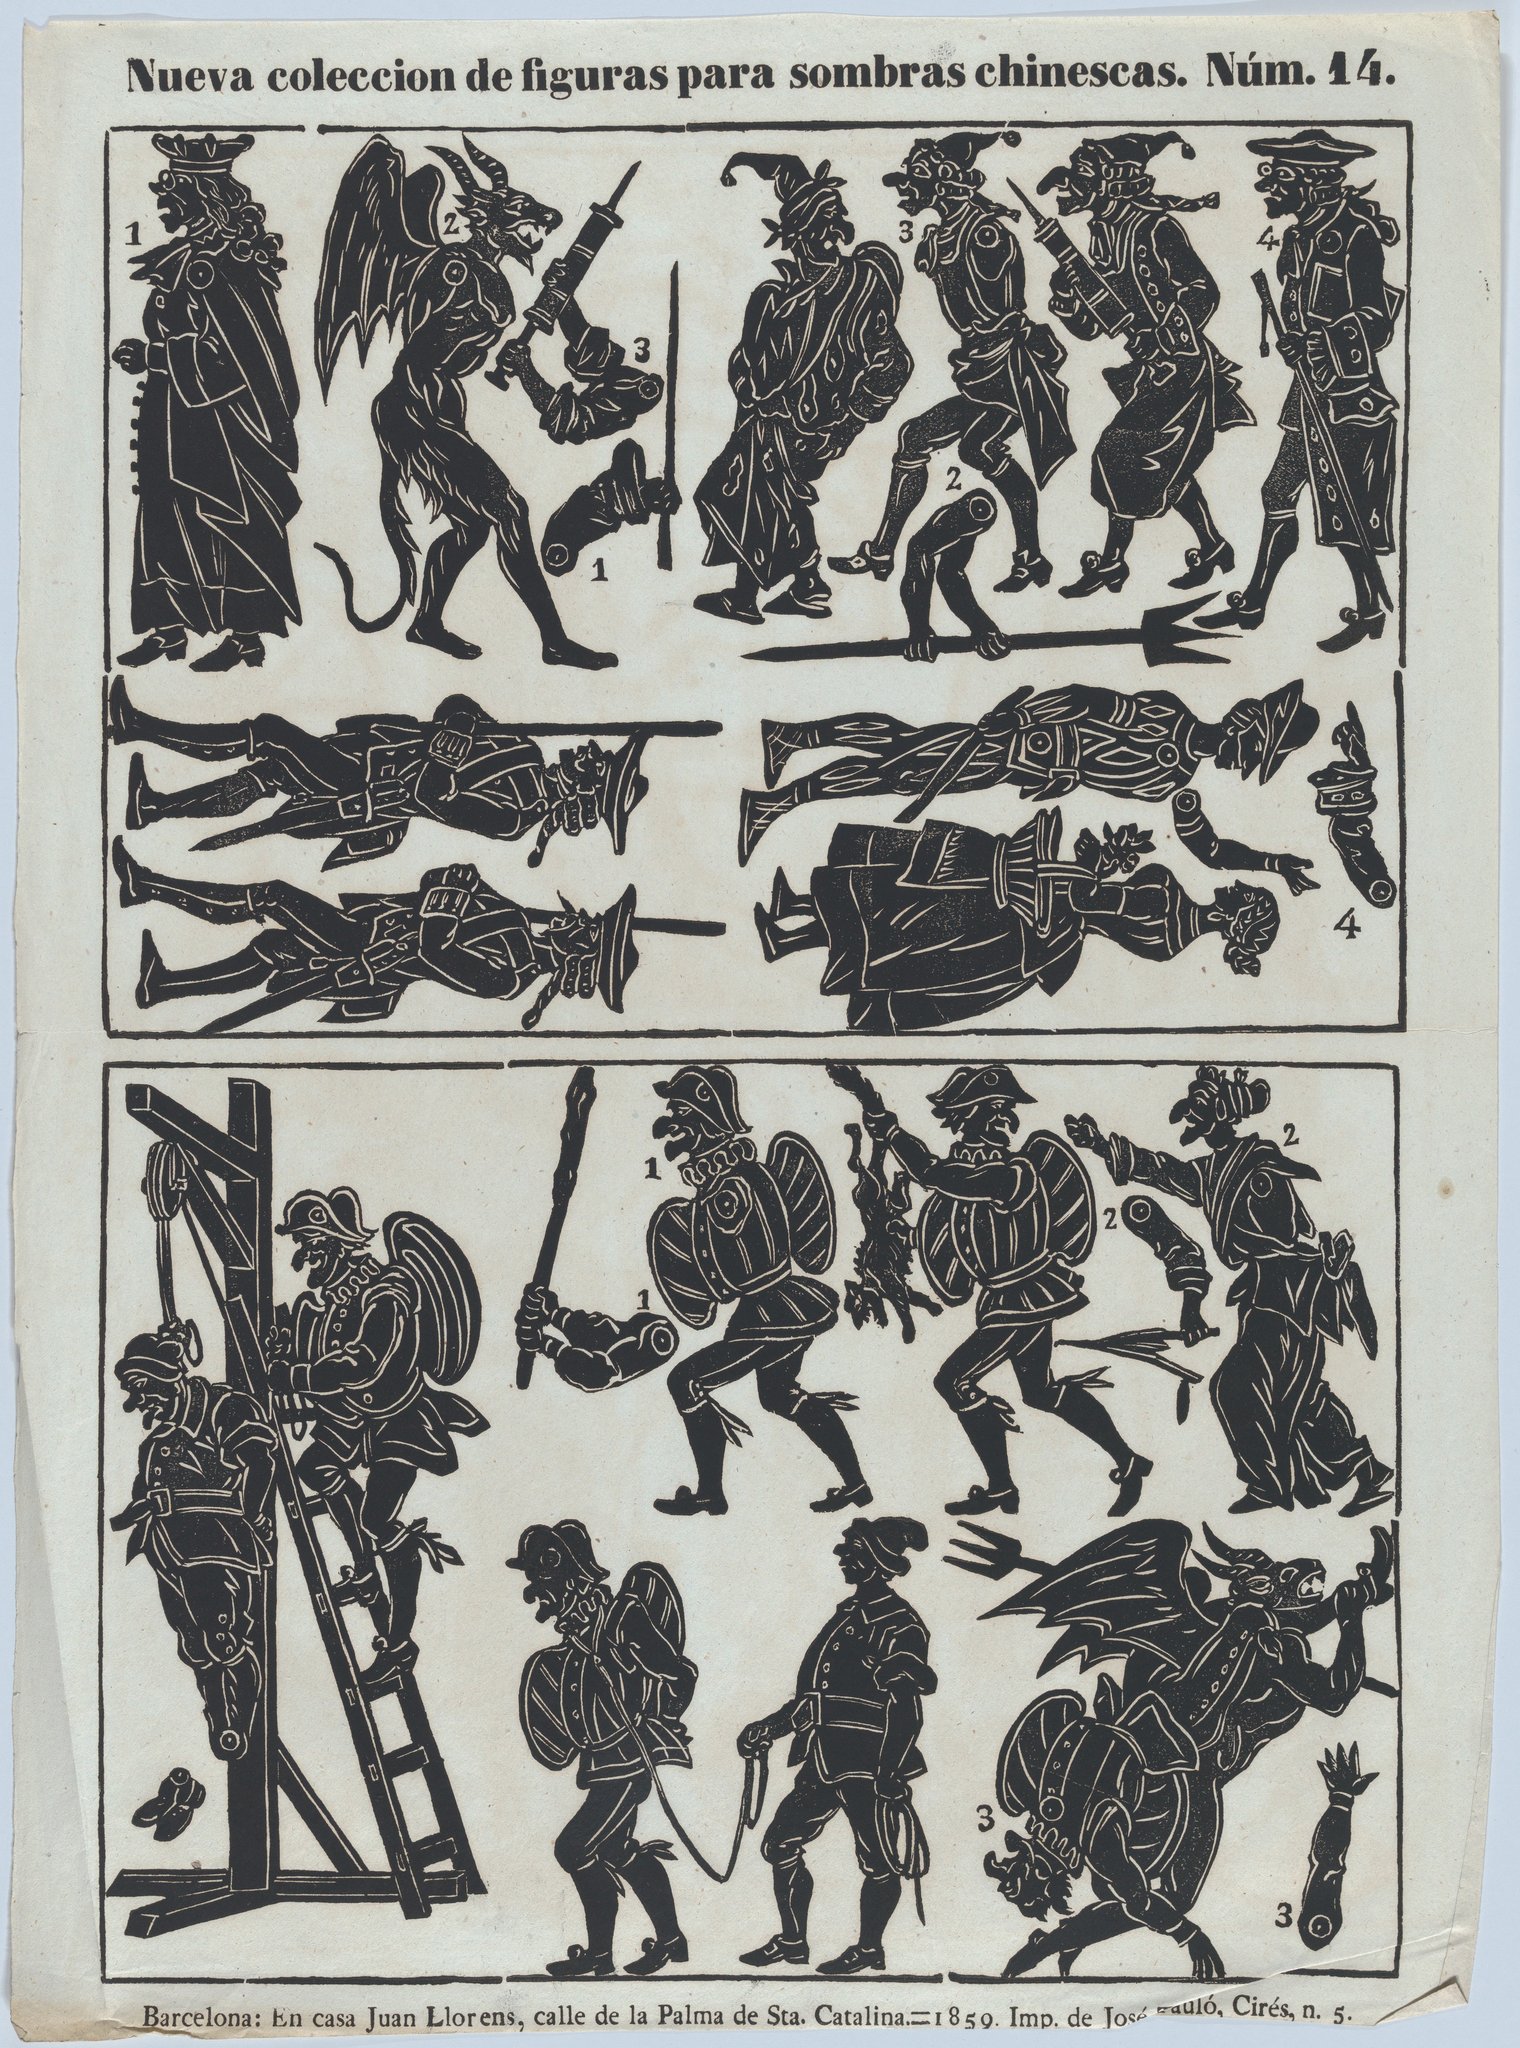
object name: print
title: Sheet 14 of figures for Chinese shadow puppets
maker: juan llorens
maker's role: publisher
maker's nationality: spanish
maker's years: 1800-1900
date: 1859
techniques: engraving, woodcut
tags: men,women,devil,puppets